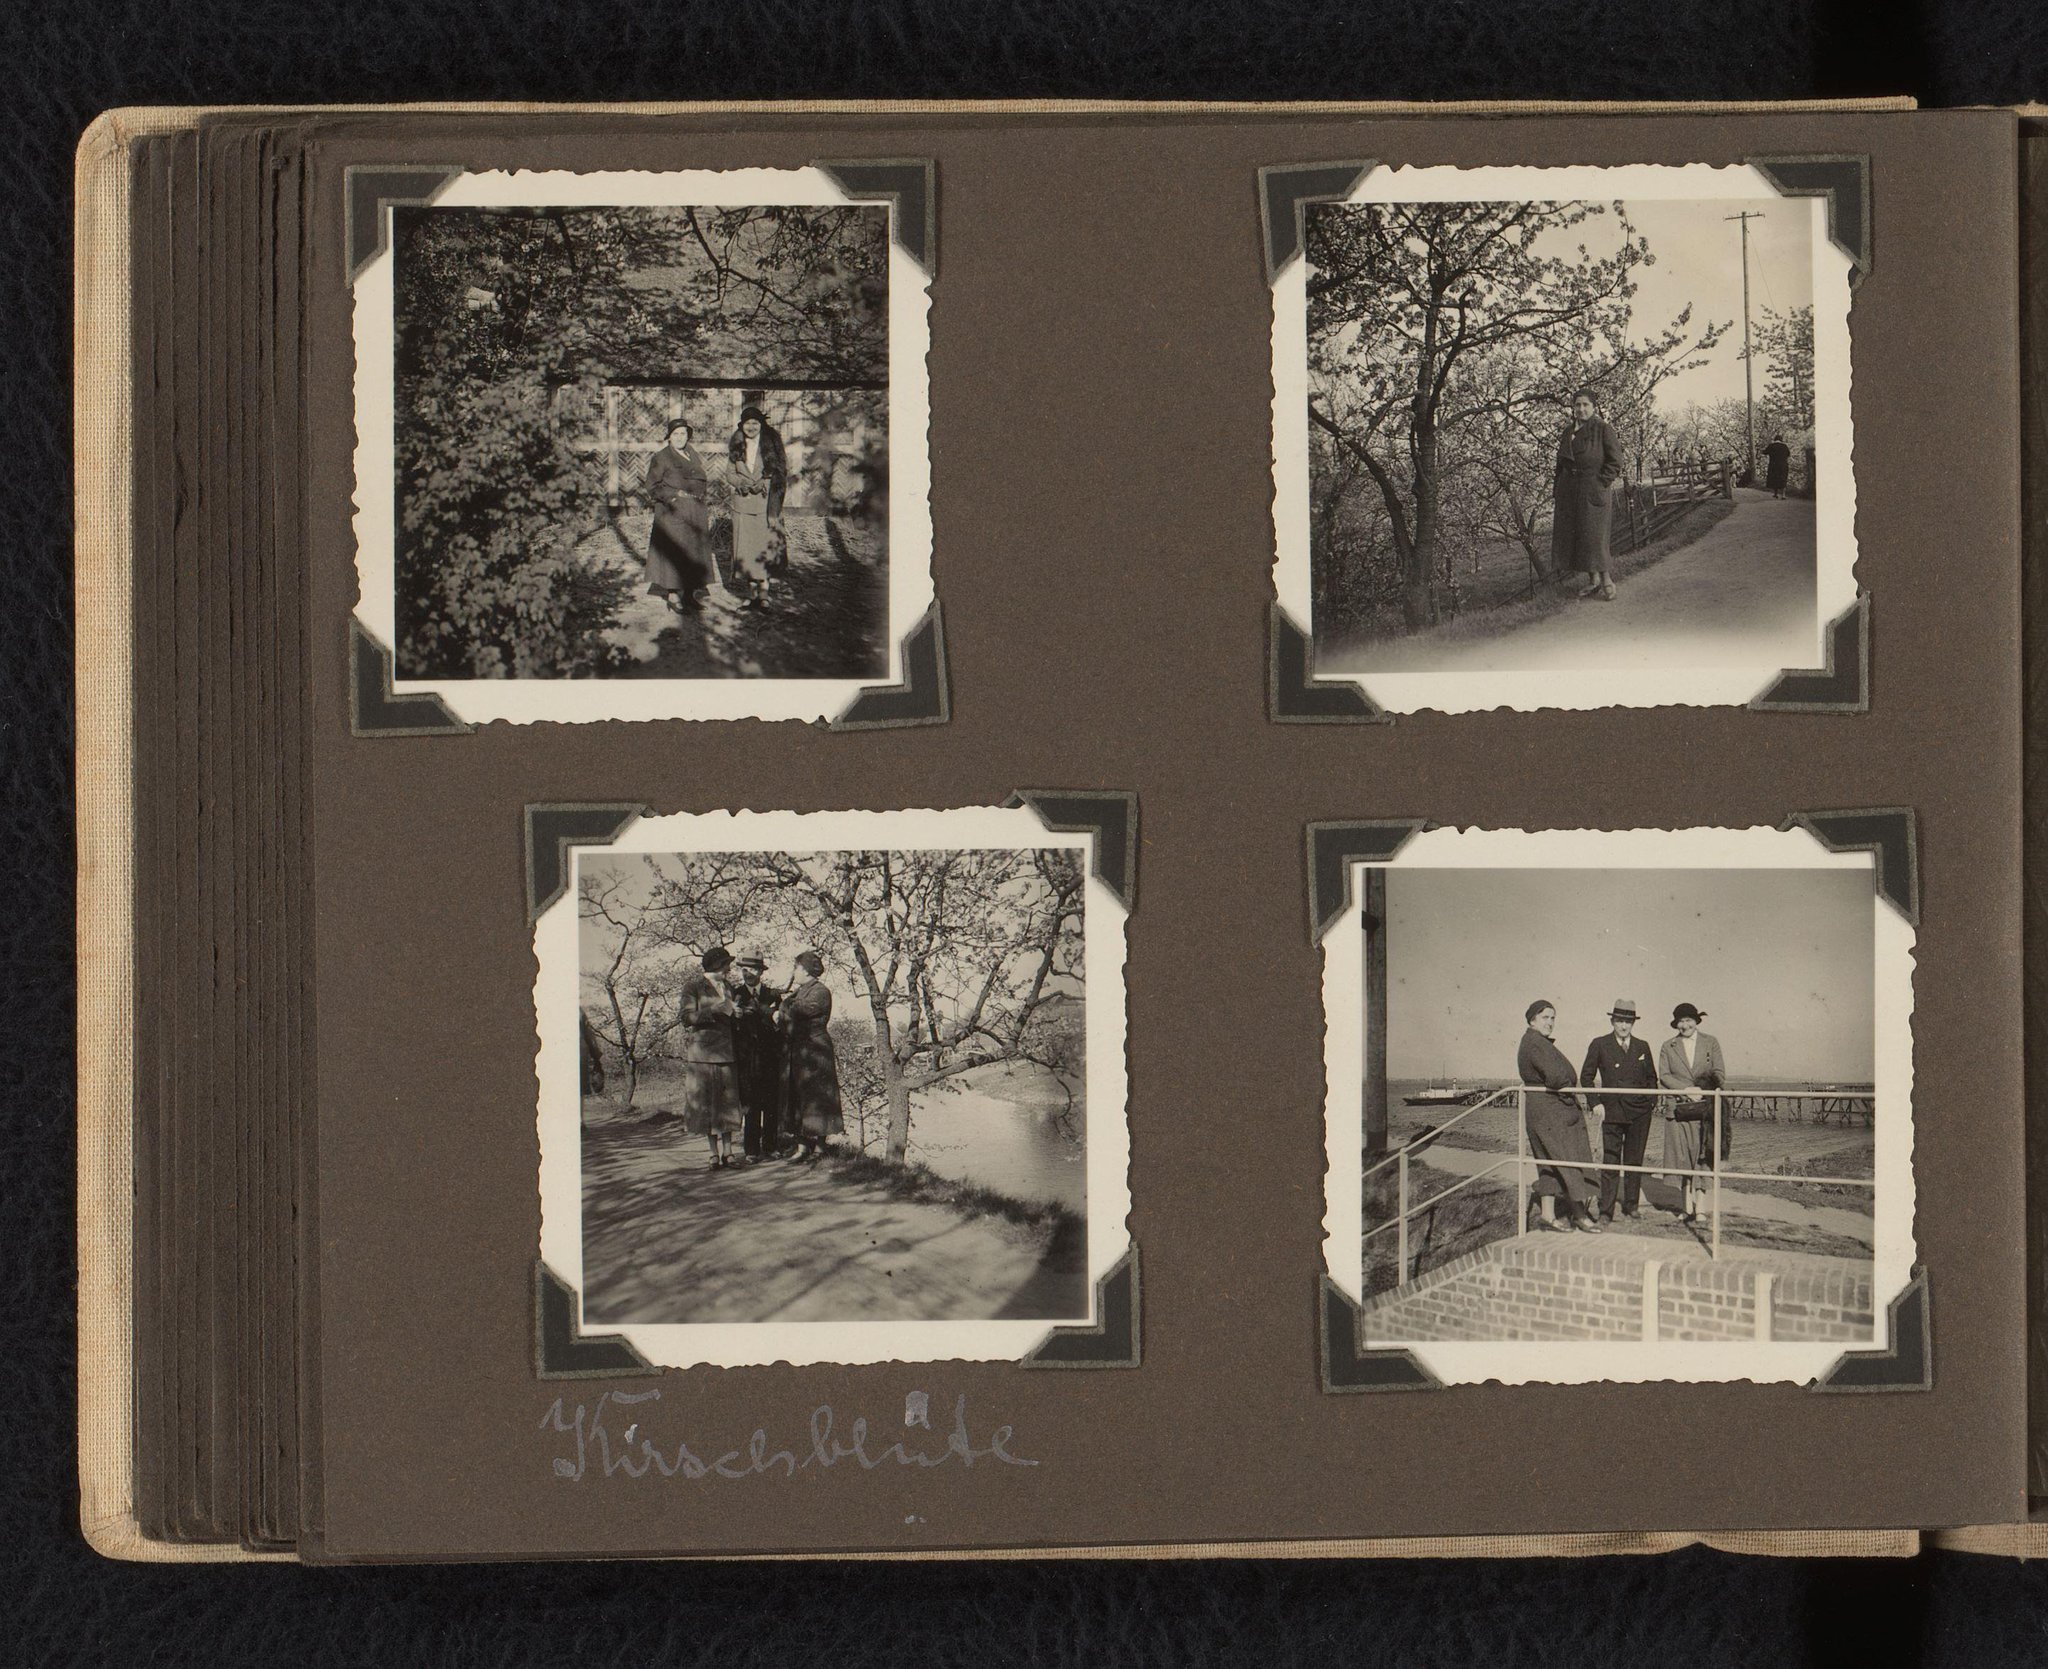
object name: photograph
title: Else Wachenheimer-Moos en haar broer Willy Moos met een onbekende tante of nicht in een tuin met Japanse kersenbloesem, mei 1932, Stade (Saksen)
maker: else wachenheimer-moos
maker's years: 1895-1944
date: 1905-1932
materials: cardboard, photographic support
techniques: gelatin silver print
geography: germany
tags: else wachenheimer-moos, willy moos, family life at home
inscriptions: inscription: ‘Kirschblüte’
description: Blad bevat vier foto's. Alle foto's van Else Wachenheimer-Moos (in donkere jas zonder hoed), Willy Moos (enige man op de foto's) en onbekende tante of nicht van de familie Moos (met hoed). Uit het album, half formaat, crèmekleurig stofomslag met koordbinding met banenmotief.